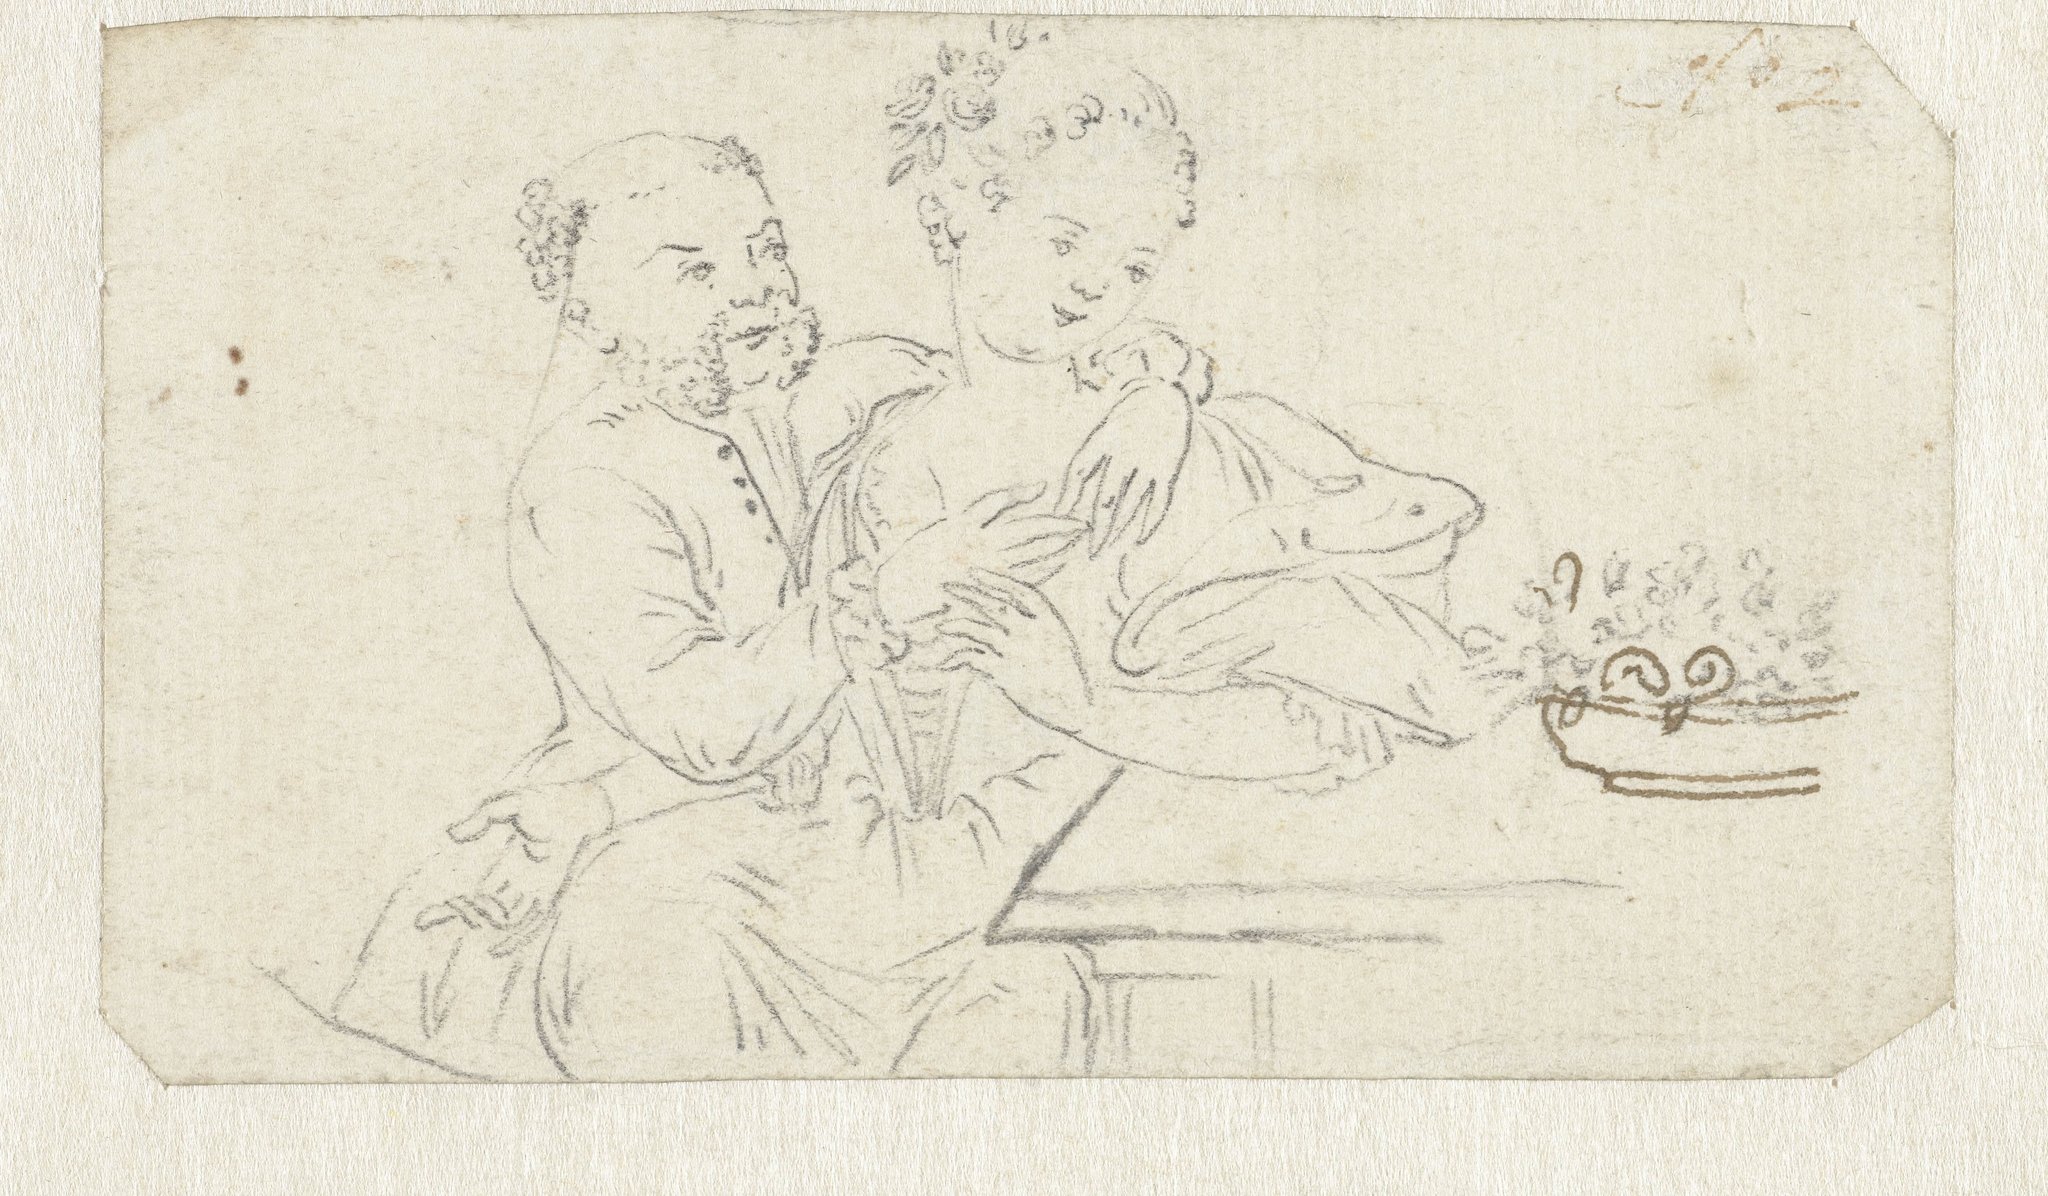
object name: drawing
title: De ongelijke liefde: jonge vrouw met een oude man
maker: dirk van der burg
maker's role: draughtsman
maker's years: 1723-1773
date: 1733-1773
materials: ink, paper, pencil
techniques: pen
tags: married couple of unequal age